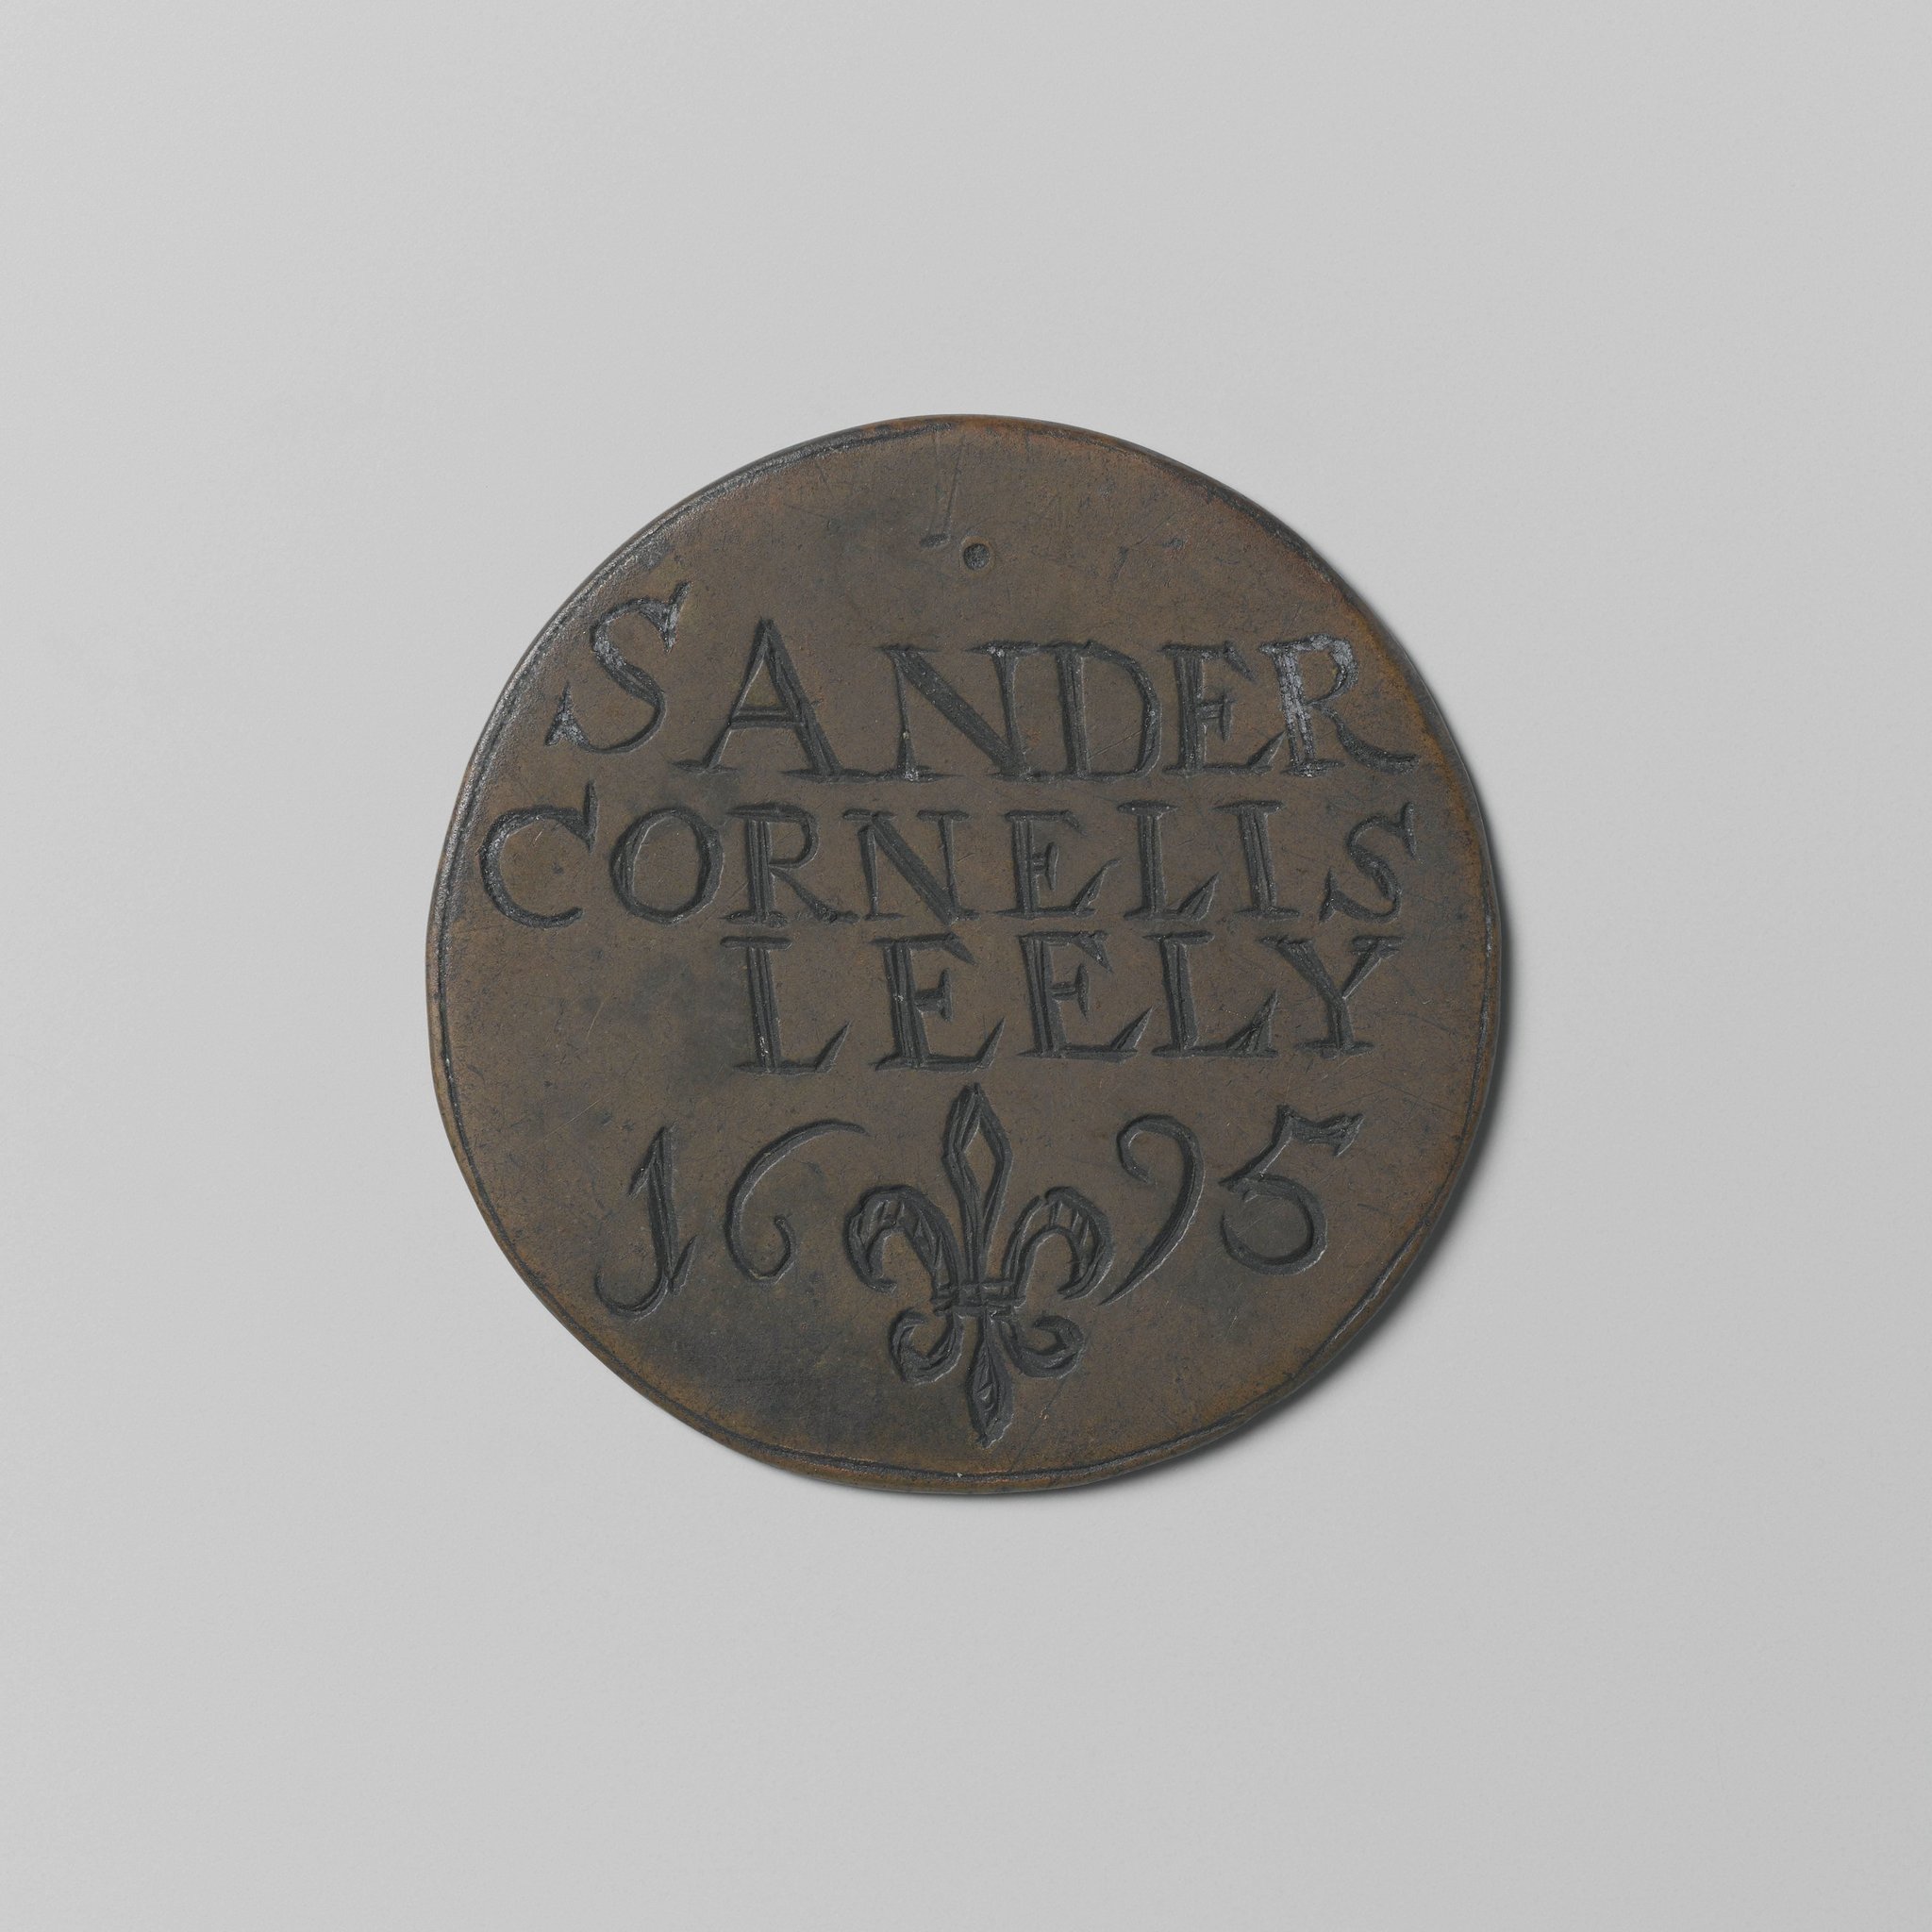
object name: medal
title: Vlotschuitvoerdersgilde van Amsterdam, gildepenning van Sander Cornelis Leely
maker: Anonymous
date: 1695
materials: brass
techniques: engraving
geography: amsterdam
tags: amsterdam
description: Messing penning. Voorzijde: schuit; daarboven datering. Keerzijde: opschrift boven jaartal, onderbroken door lelie